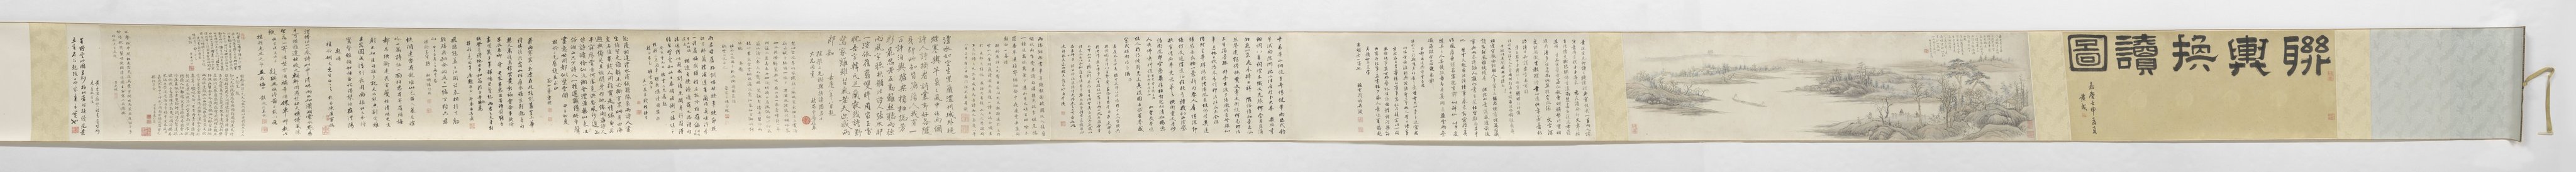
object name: handscroll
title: Handrol, twee ambtenaren met gevolg op reis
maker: zhu henian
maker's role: painter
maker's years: 1760-1834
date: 1803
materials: ink, paper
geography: taizhou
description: Travelling officials. Zhu Henian. China. 1803. Ink and colours on paper. This painting shows the accidental meeting of two officials travelling from one post to another. Seated in their sedan chairs, they began to recite poems. They enjoyed themselves so much that they decided to travel together for two days. Two years later the painter Zhu Henian was commissioned to immortalize the event. One of the officials had decided to give the scroll painting as a memento to the other.